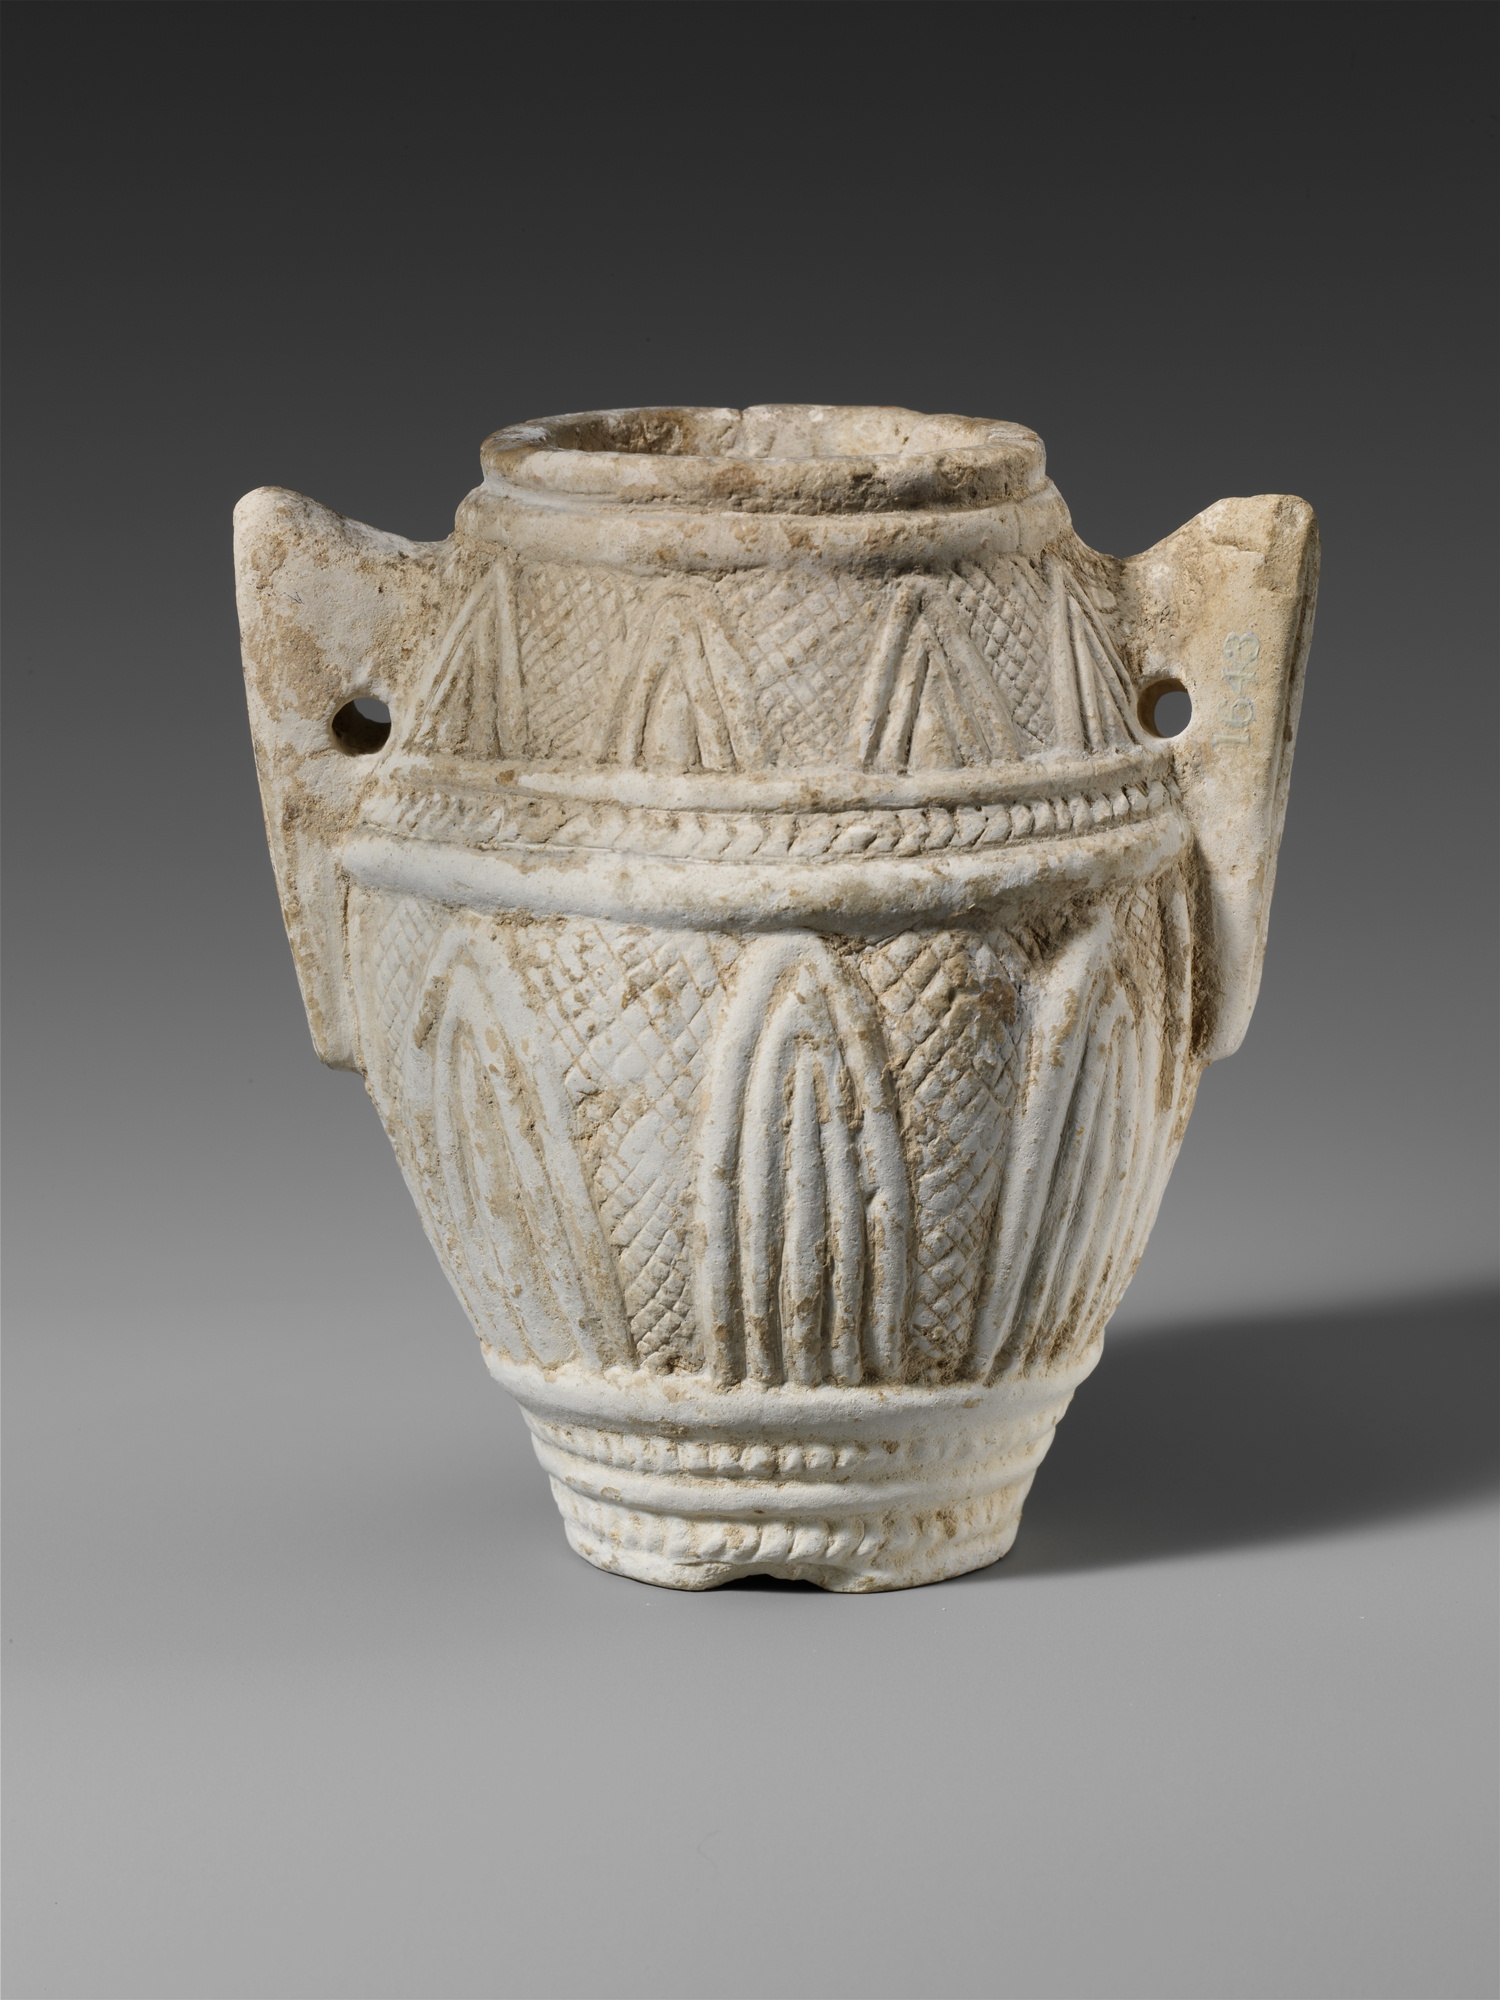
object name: vase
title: Miniature limestone amphora (jar)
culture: cypriot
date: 1200-1100 BCE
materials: limestone